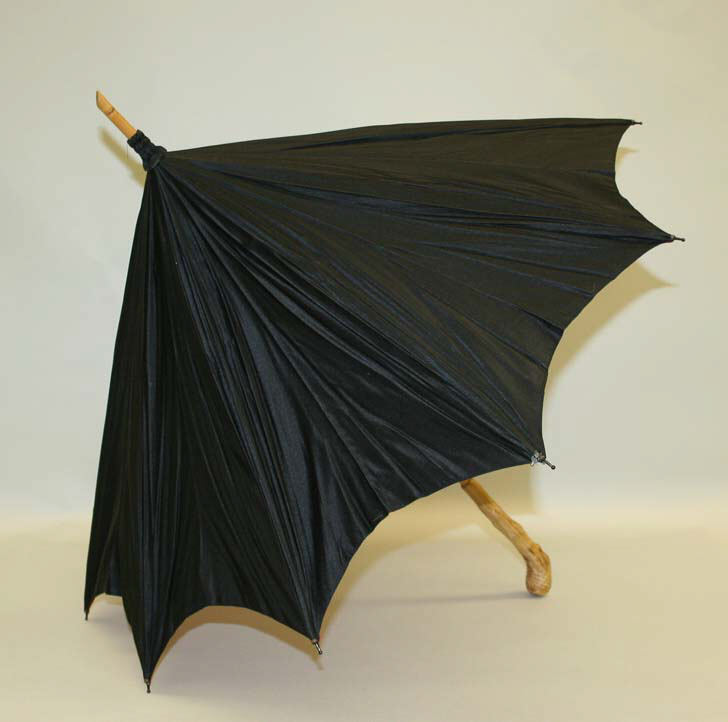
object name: parasol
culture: american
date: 1870-1889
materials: wood